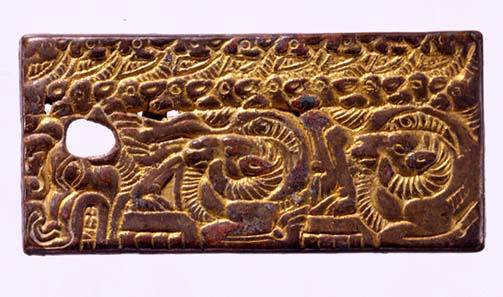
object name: belt buckle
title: Belt Buckle with Zoomorphic Design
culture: north chinese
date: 300-101 BCE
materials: bronze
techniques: gilding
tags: animals